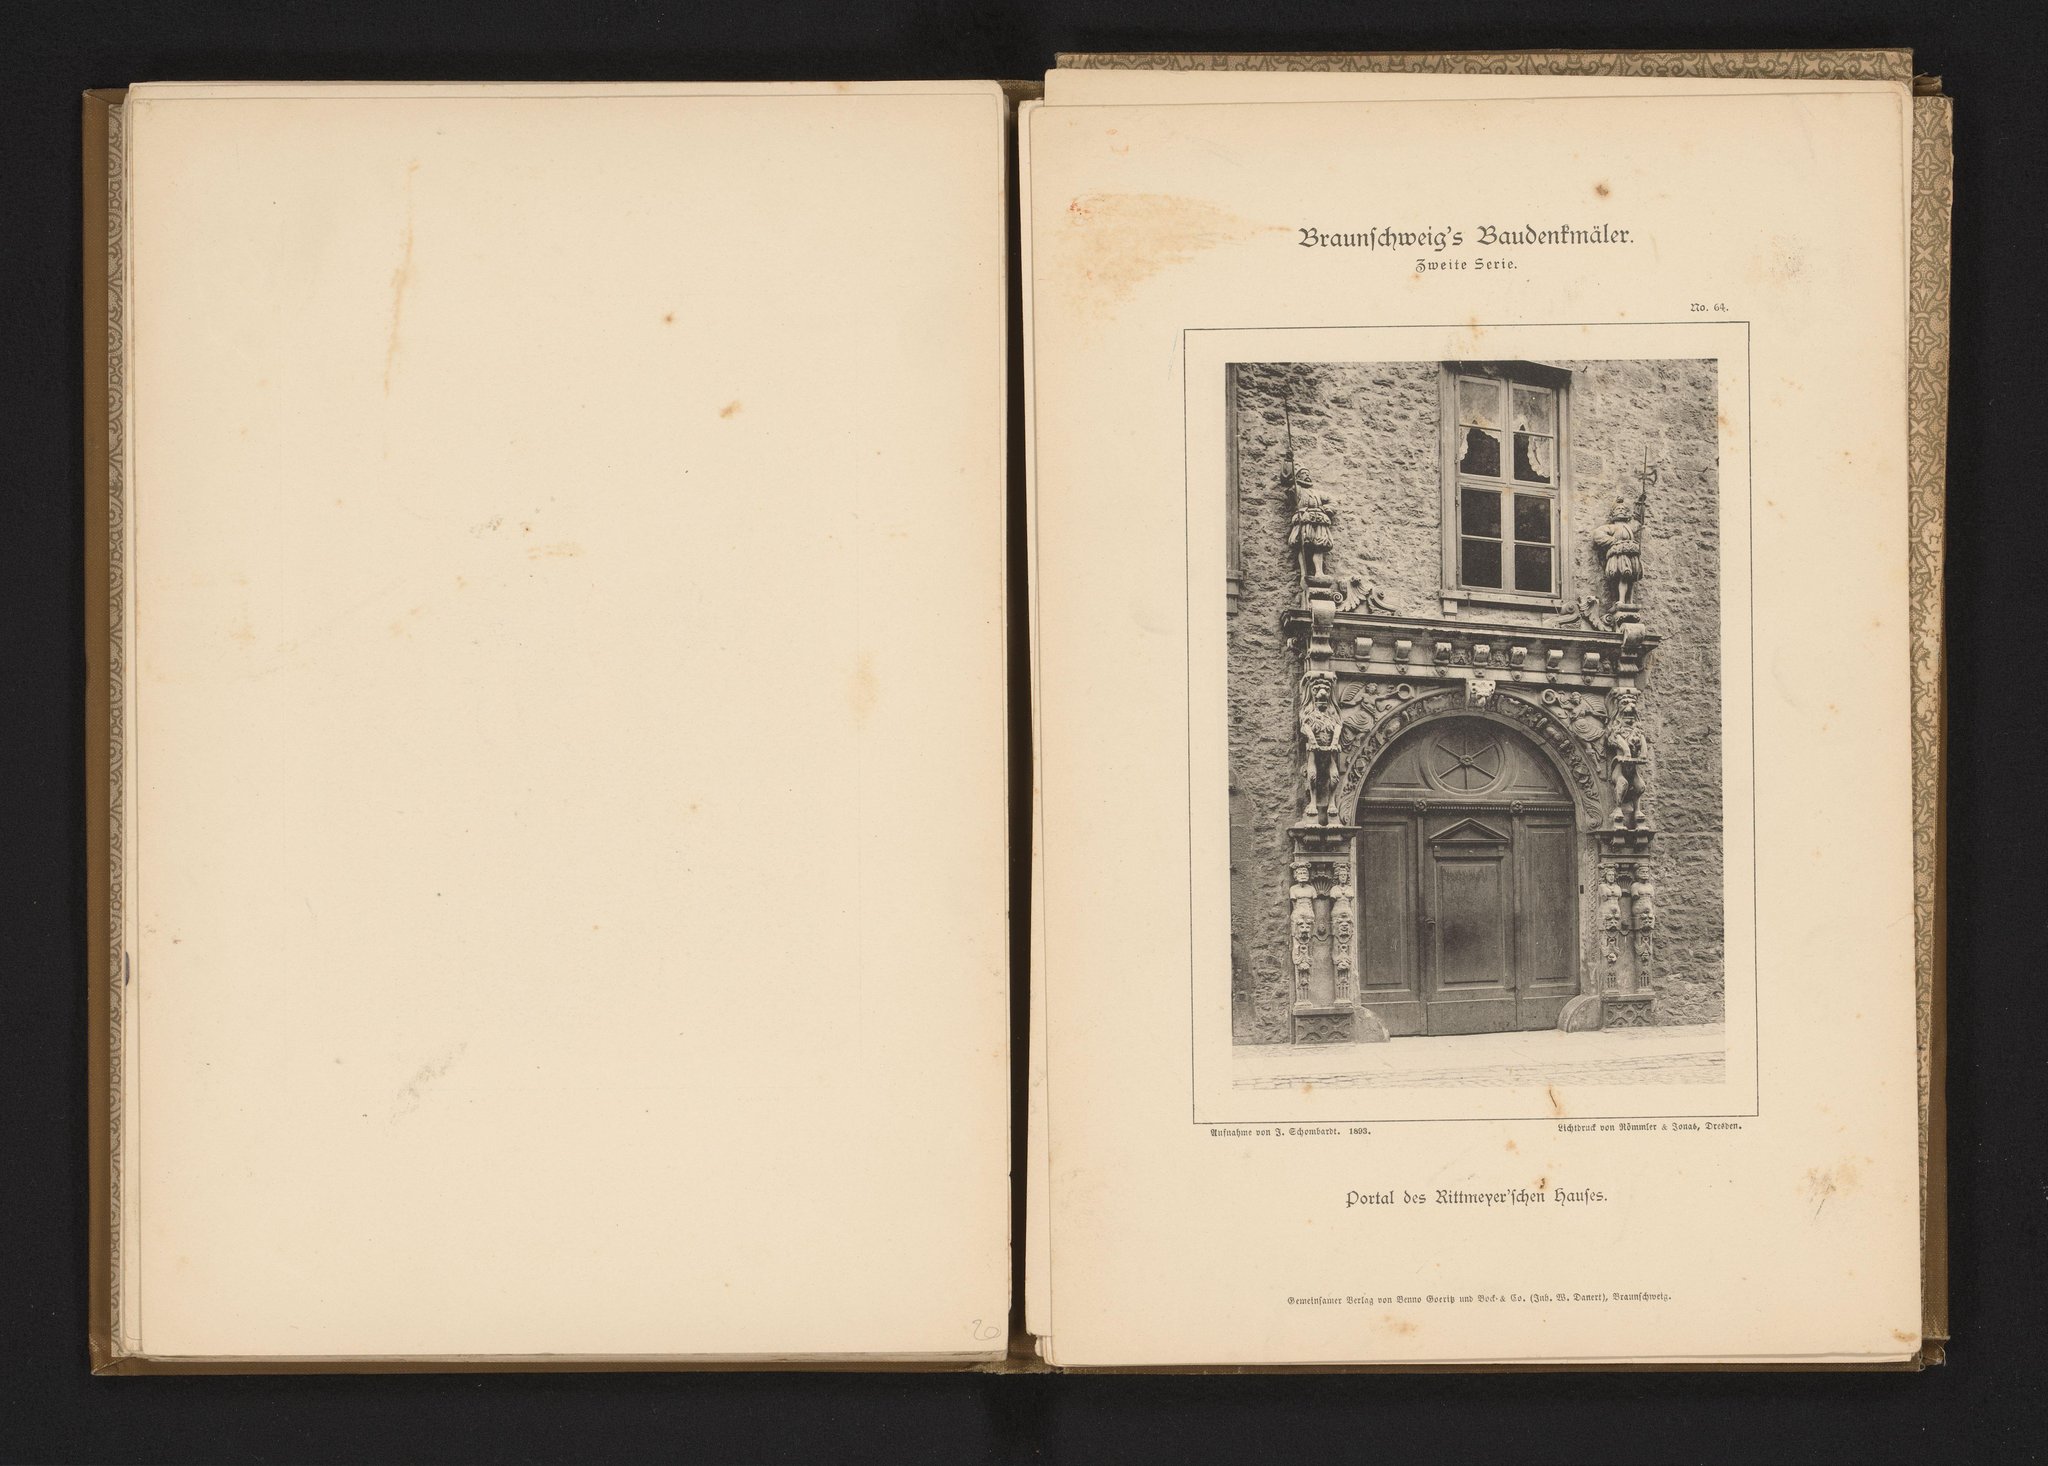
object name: page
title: Braunschweig's Baudenkmäler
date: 1893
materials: paper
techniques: photograph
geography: braunschweig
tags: housing, gate, entrance, façade (of house or building)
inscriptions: number: ‘No. 64.’